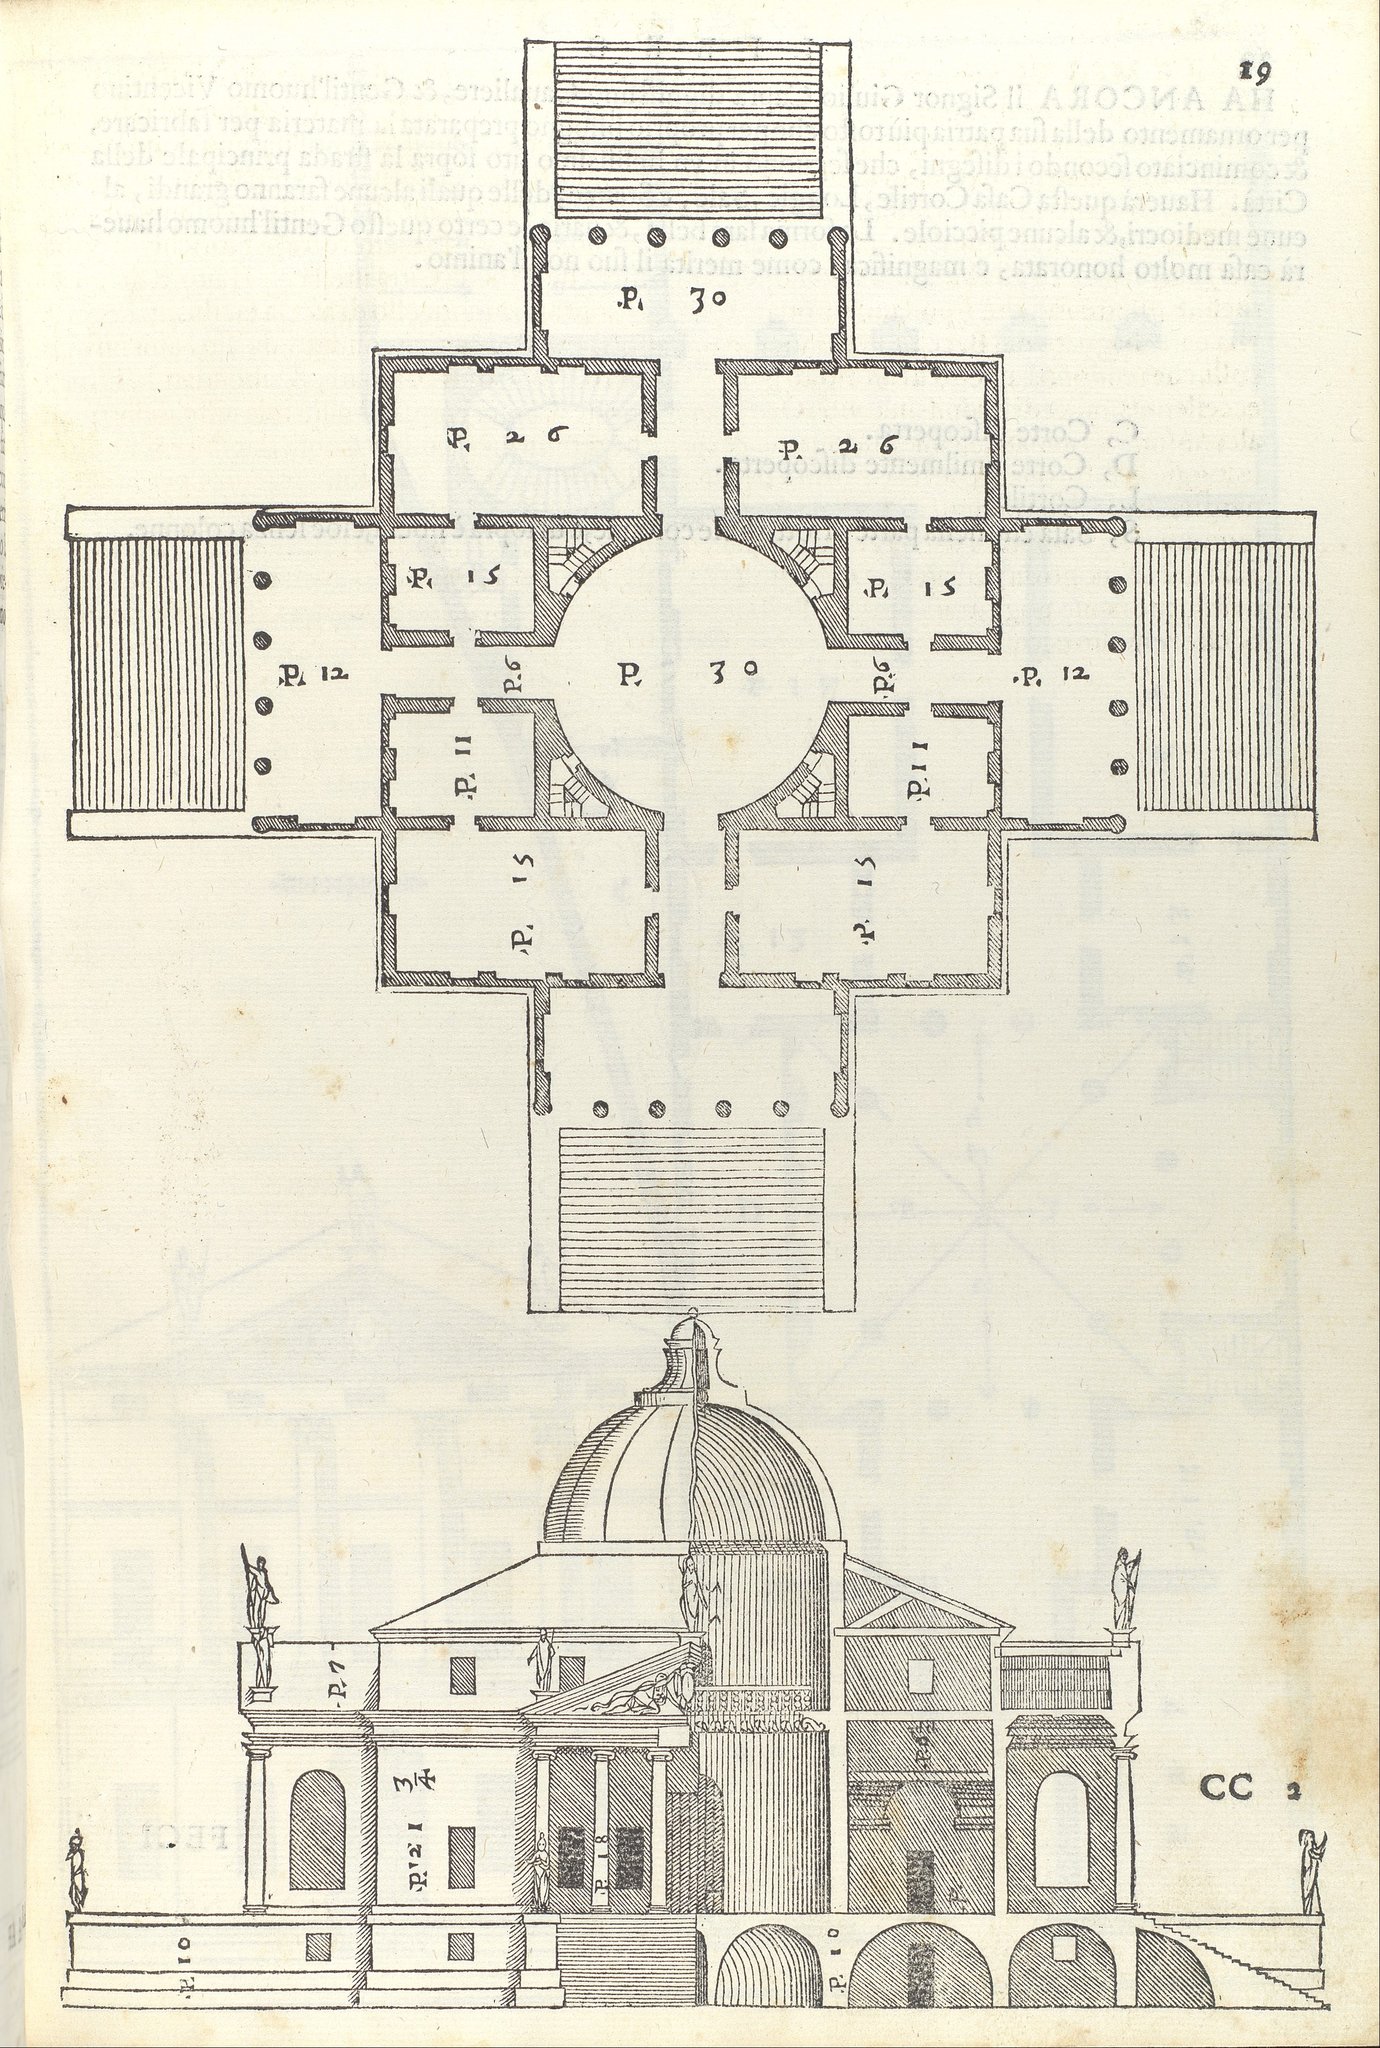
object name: book print ornament architecture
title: I quattro libri dell'architettura di Andrea Palladio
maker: andrea palladio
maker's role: author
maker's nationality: italian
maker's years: 1508-1580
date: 1570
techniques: printing, woodcut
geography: italy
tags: architecture,buildings